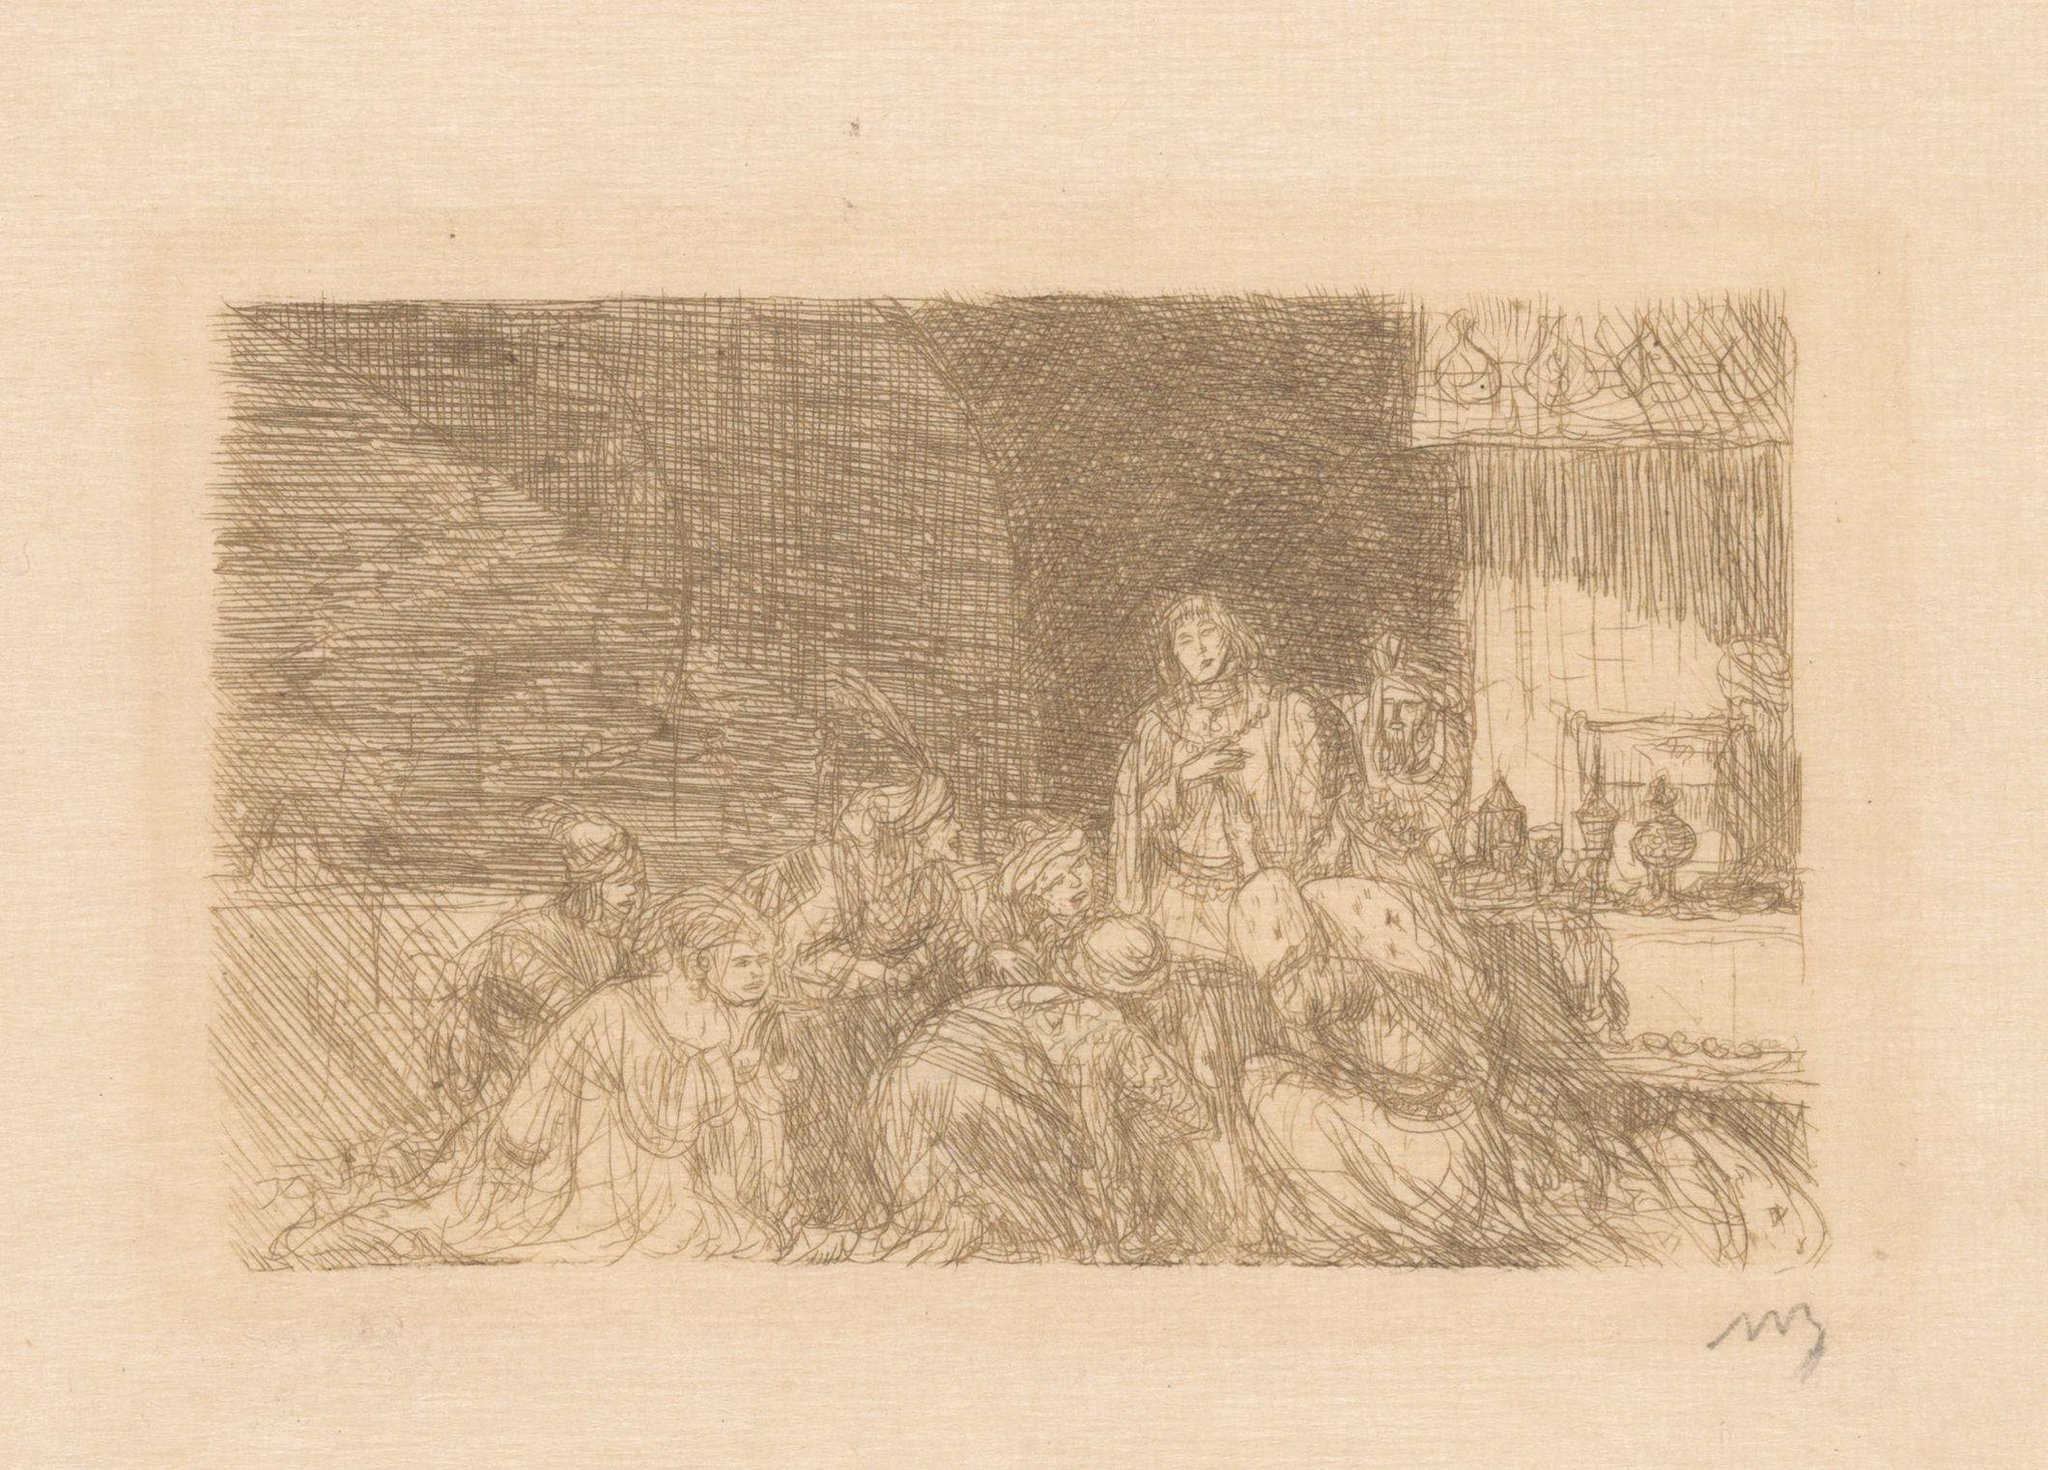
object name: print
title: Knielende figuren rondom een staande figuur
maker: marius bauer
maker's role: draughtsman, print maker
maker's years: 1867-1932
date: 1897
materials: paper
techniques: etching, intaglio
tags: tales and fairy tales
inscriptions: collector's mark: Lugt 2228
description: Bauer vervaardigde deze ets voor zijn prentenserie naar het Roemeense sprookje 'La jeunesse inaltérable et la vie éternelle'.